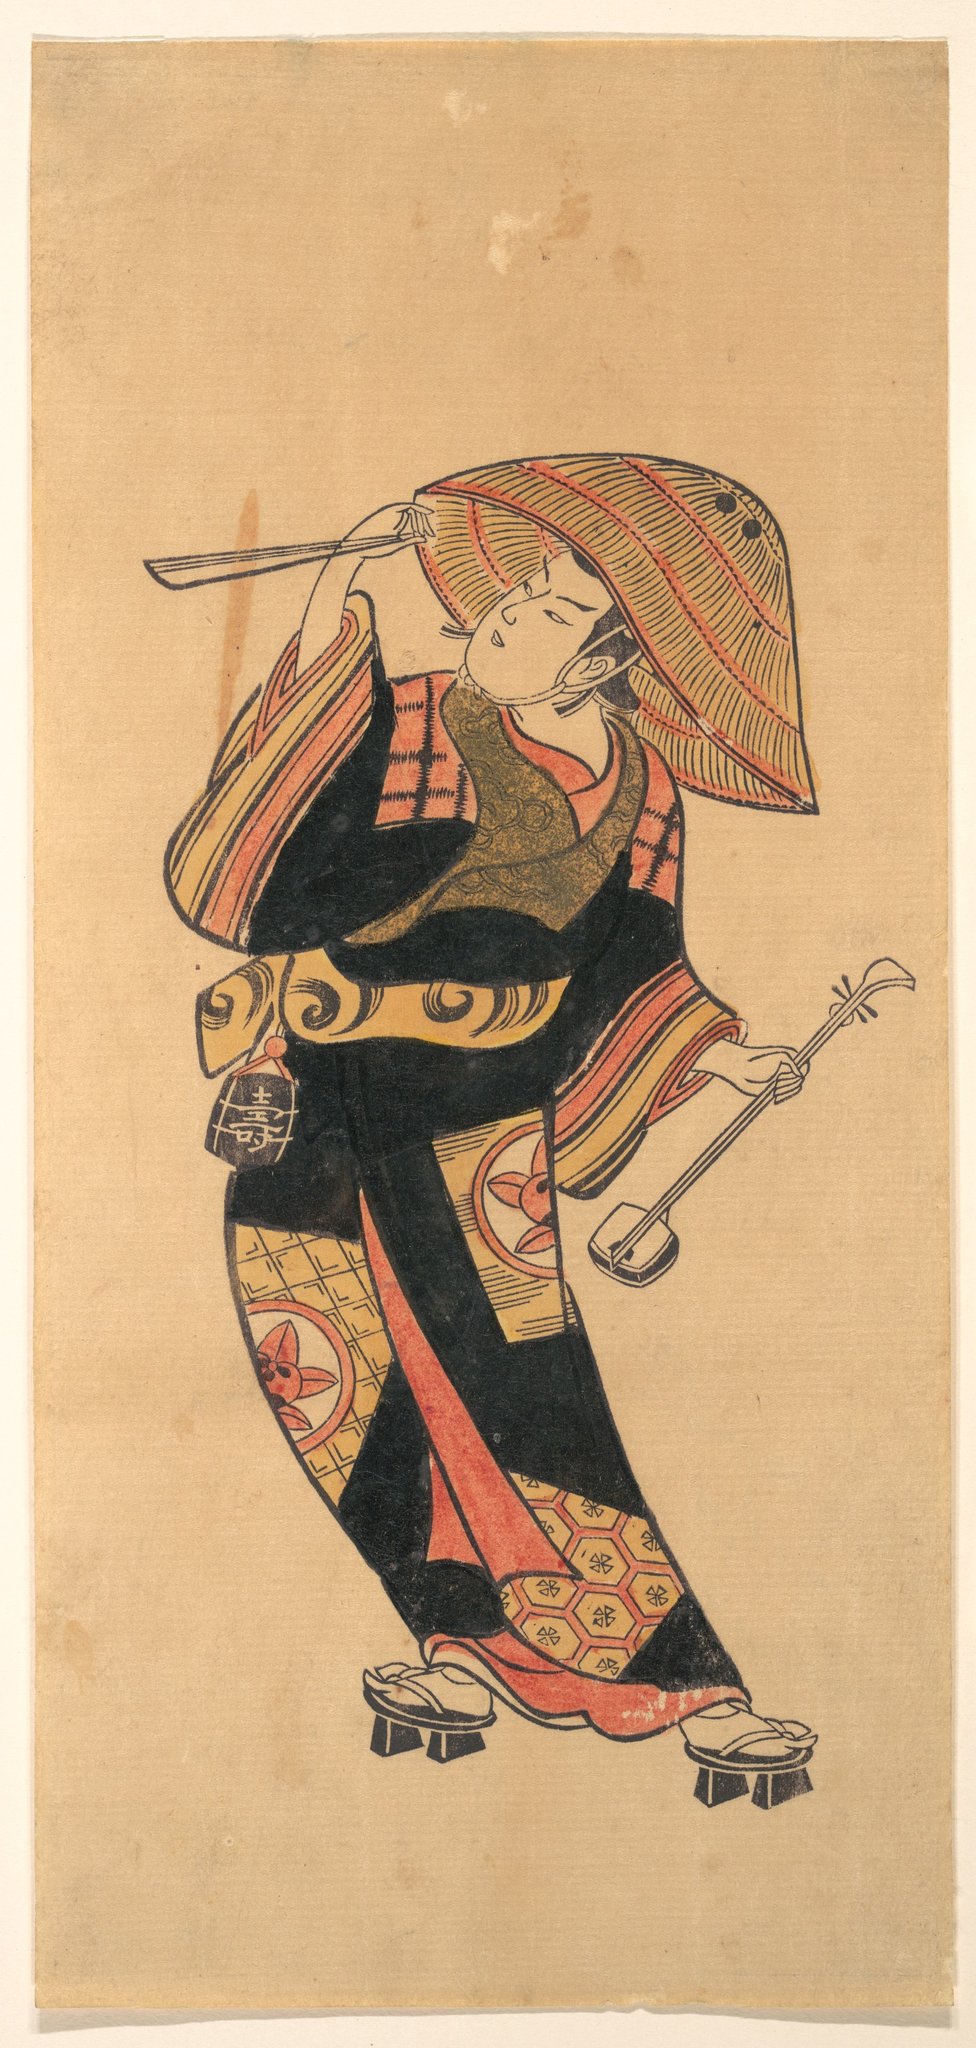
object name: print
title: Ichimura Takenojo VIII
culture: japanese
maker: torii kiyotomo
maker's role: artist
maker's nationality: japanese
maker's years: 1815-1820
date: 1720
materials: ink, paper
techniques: hand coloring, woodblock print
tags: musical instruments,men,actors